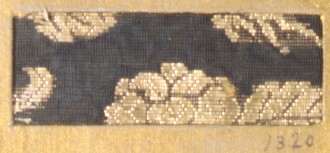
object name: piece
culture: japanese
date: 1701-1900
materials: silk